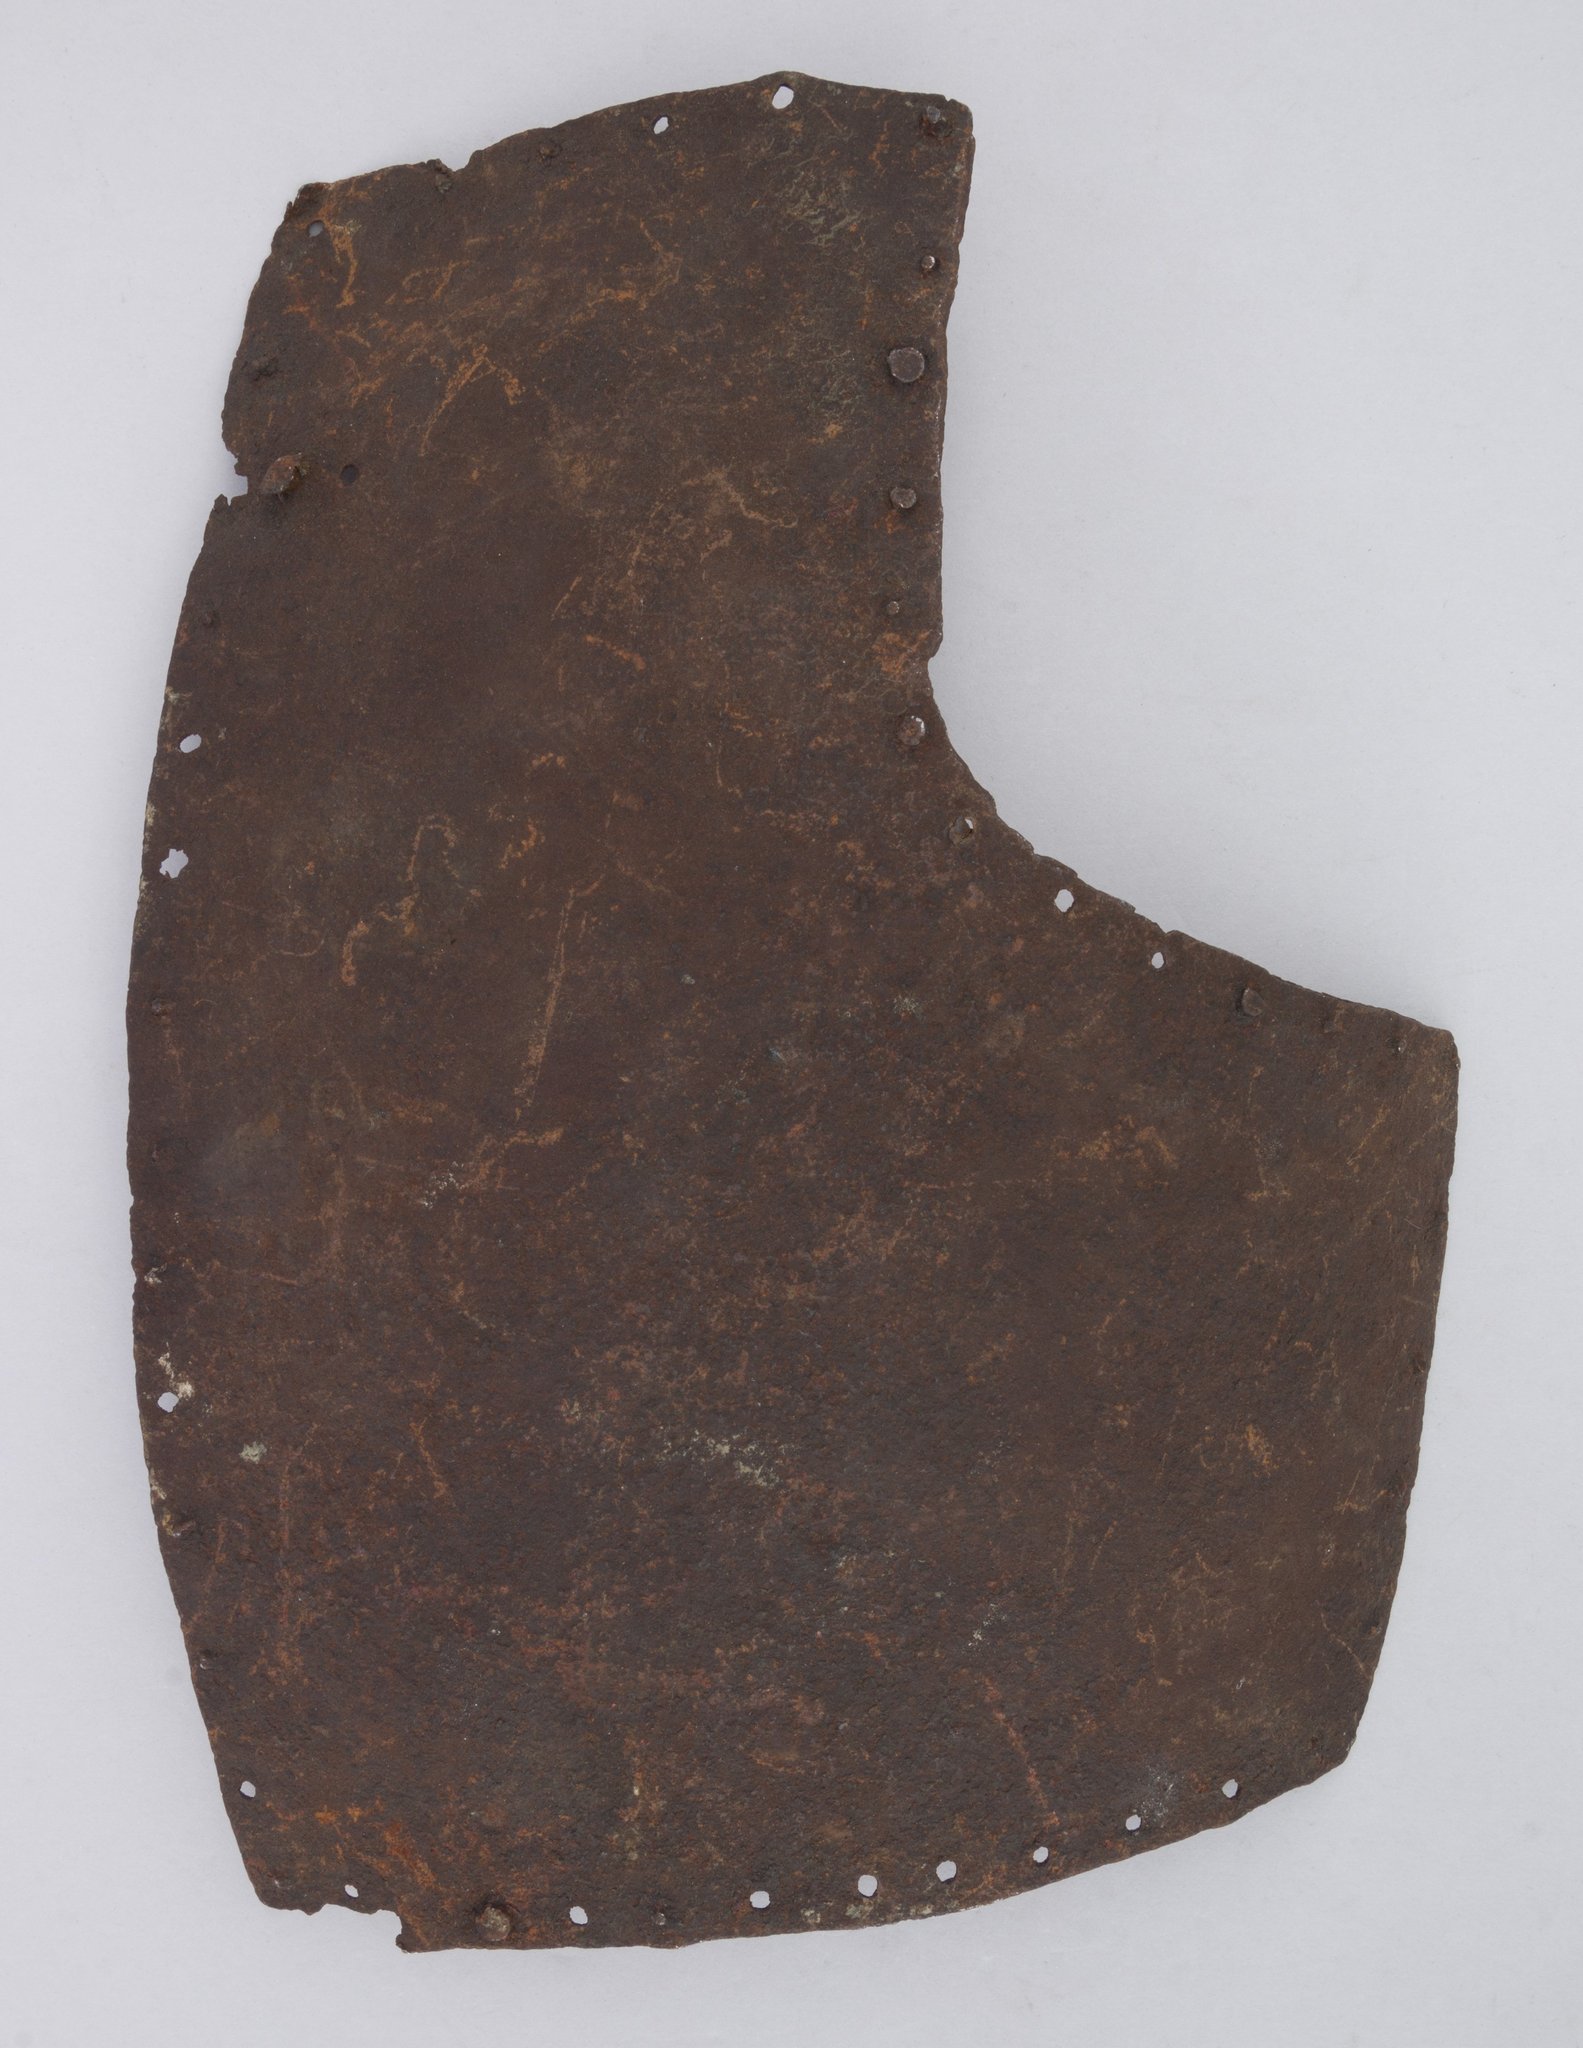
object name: brigandine plate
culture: italian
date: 1400-1450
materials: metal alloy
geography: italy